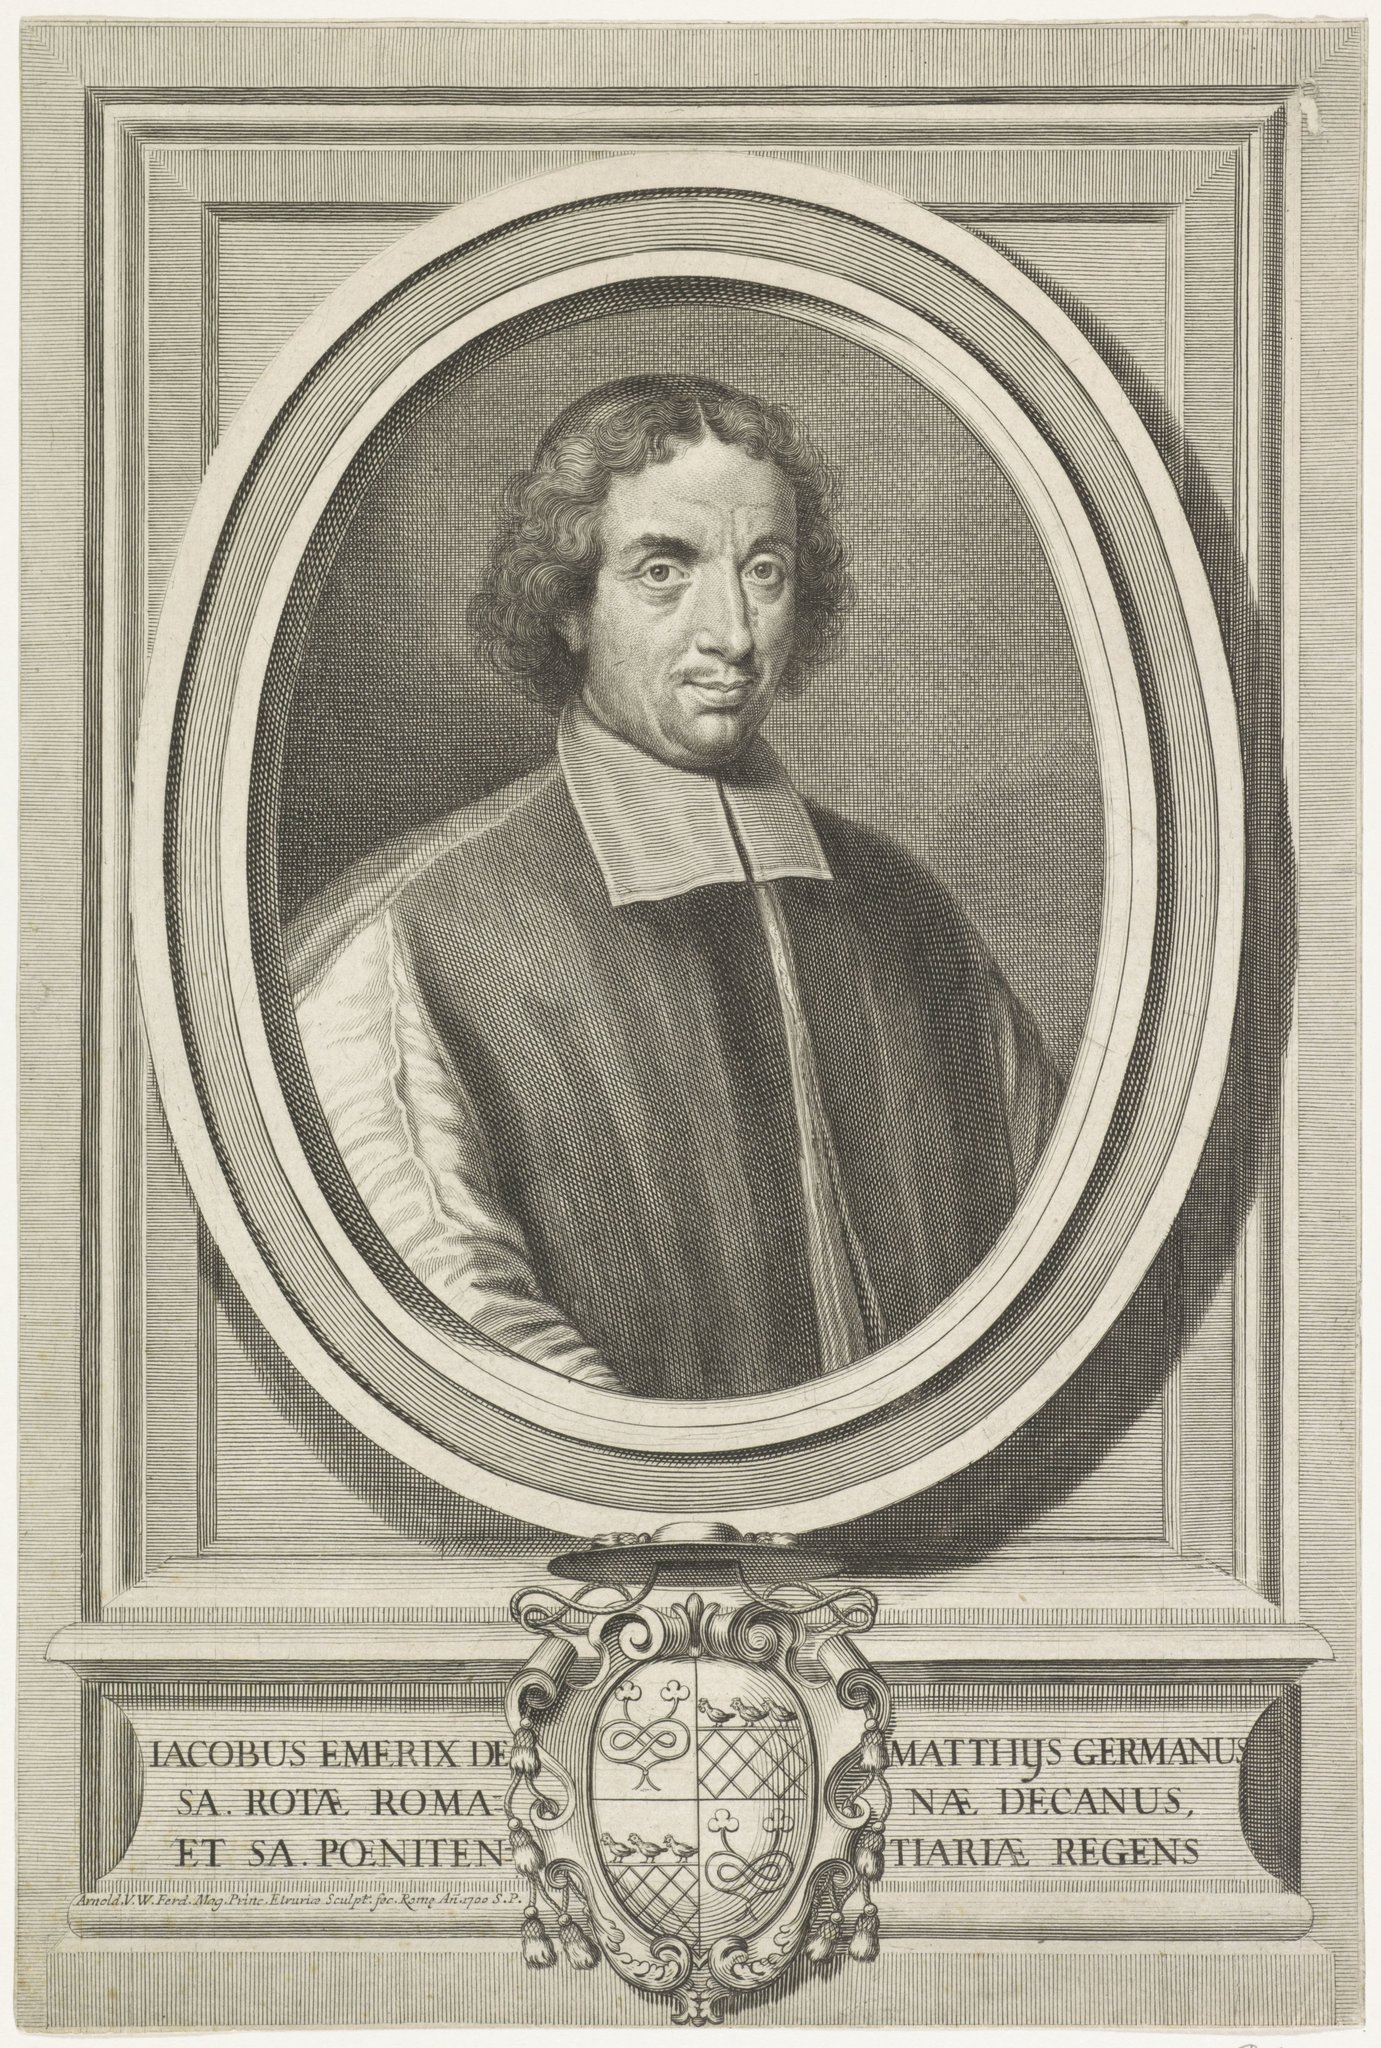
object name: print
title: Portret van Jacobus Emerix de Matthijs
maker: arnold van westerhout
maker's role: print maker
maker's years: 1651-1725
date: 1700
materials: paper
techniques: engraving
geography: rome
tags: bilzen, rome, armorial bearing, heraldry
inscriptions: collector's mark: Lugt 2233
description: De prent is ook als boekillustratie gebruikt in: Jacobus Emerix de Matthijs, Decisiones Sacrae Rotae Romanae coram bon. mem. R.P.D. Joanne Emerix Germano, ejusdem Sacrae Rotae auditore (...), deel 1, Rome 1701.